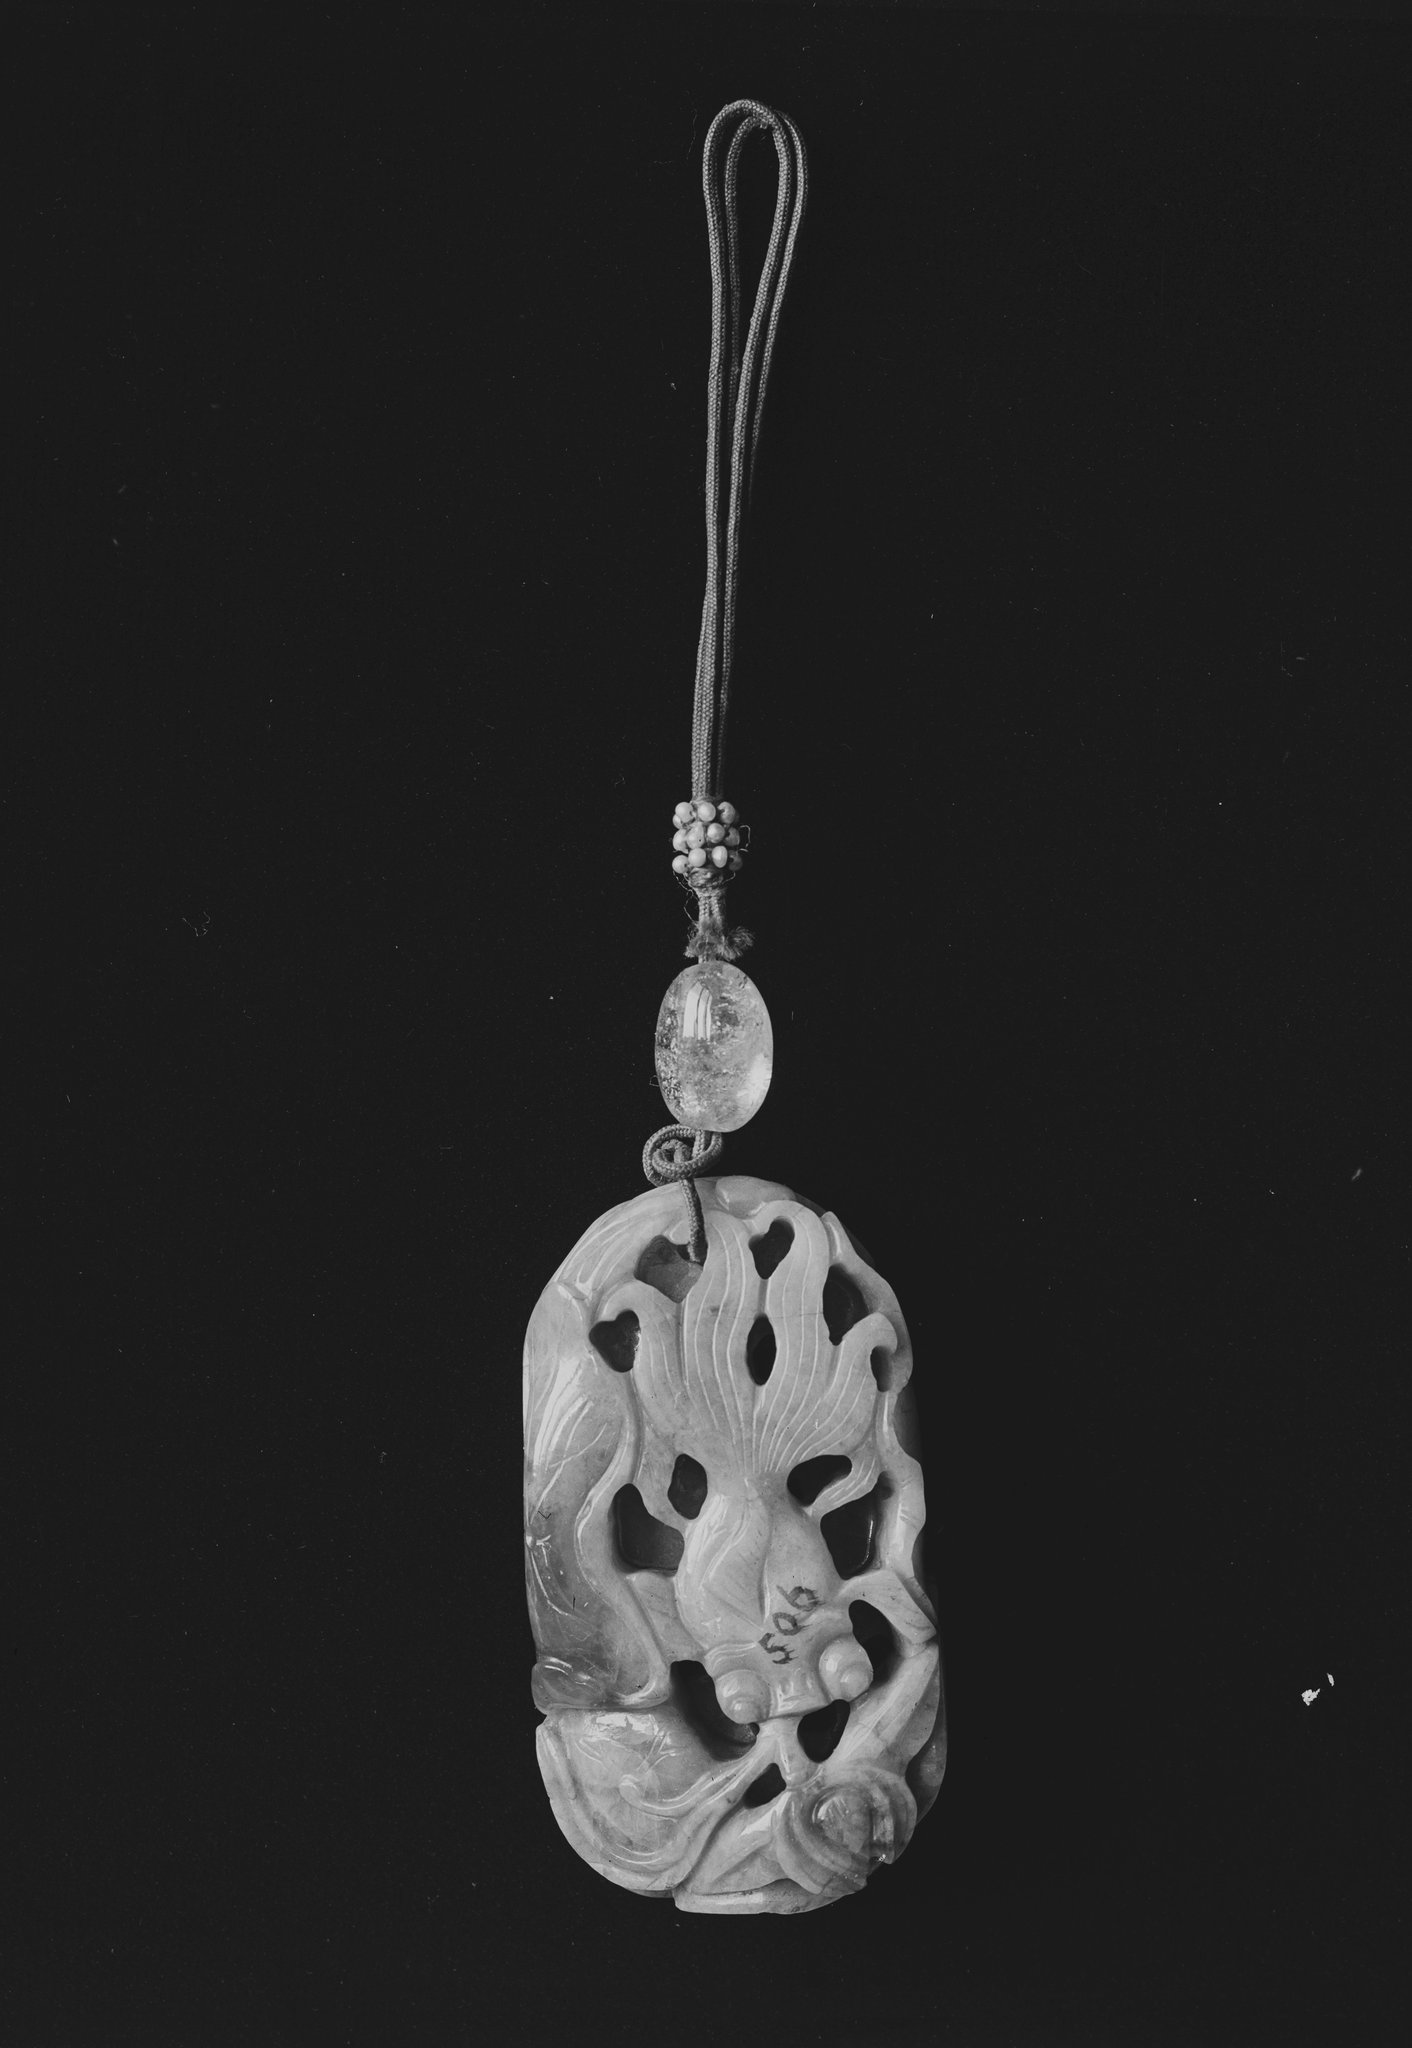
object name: pendant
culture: chinese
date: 1736-1795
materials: gemstone, jade